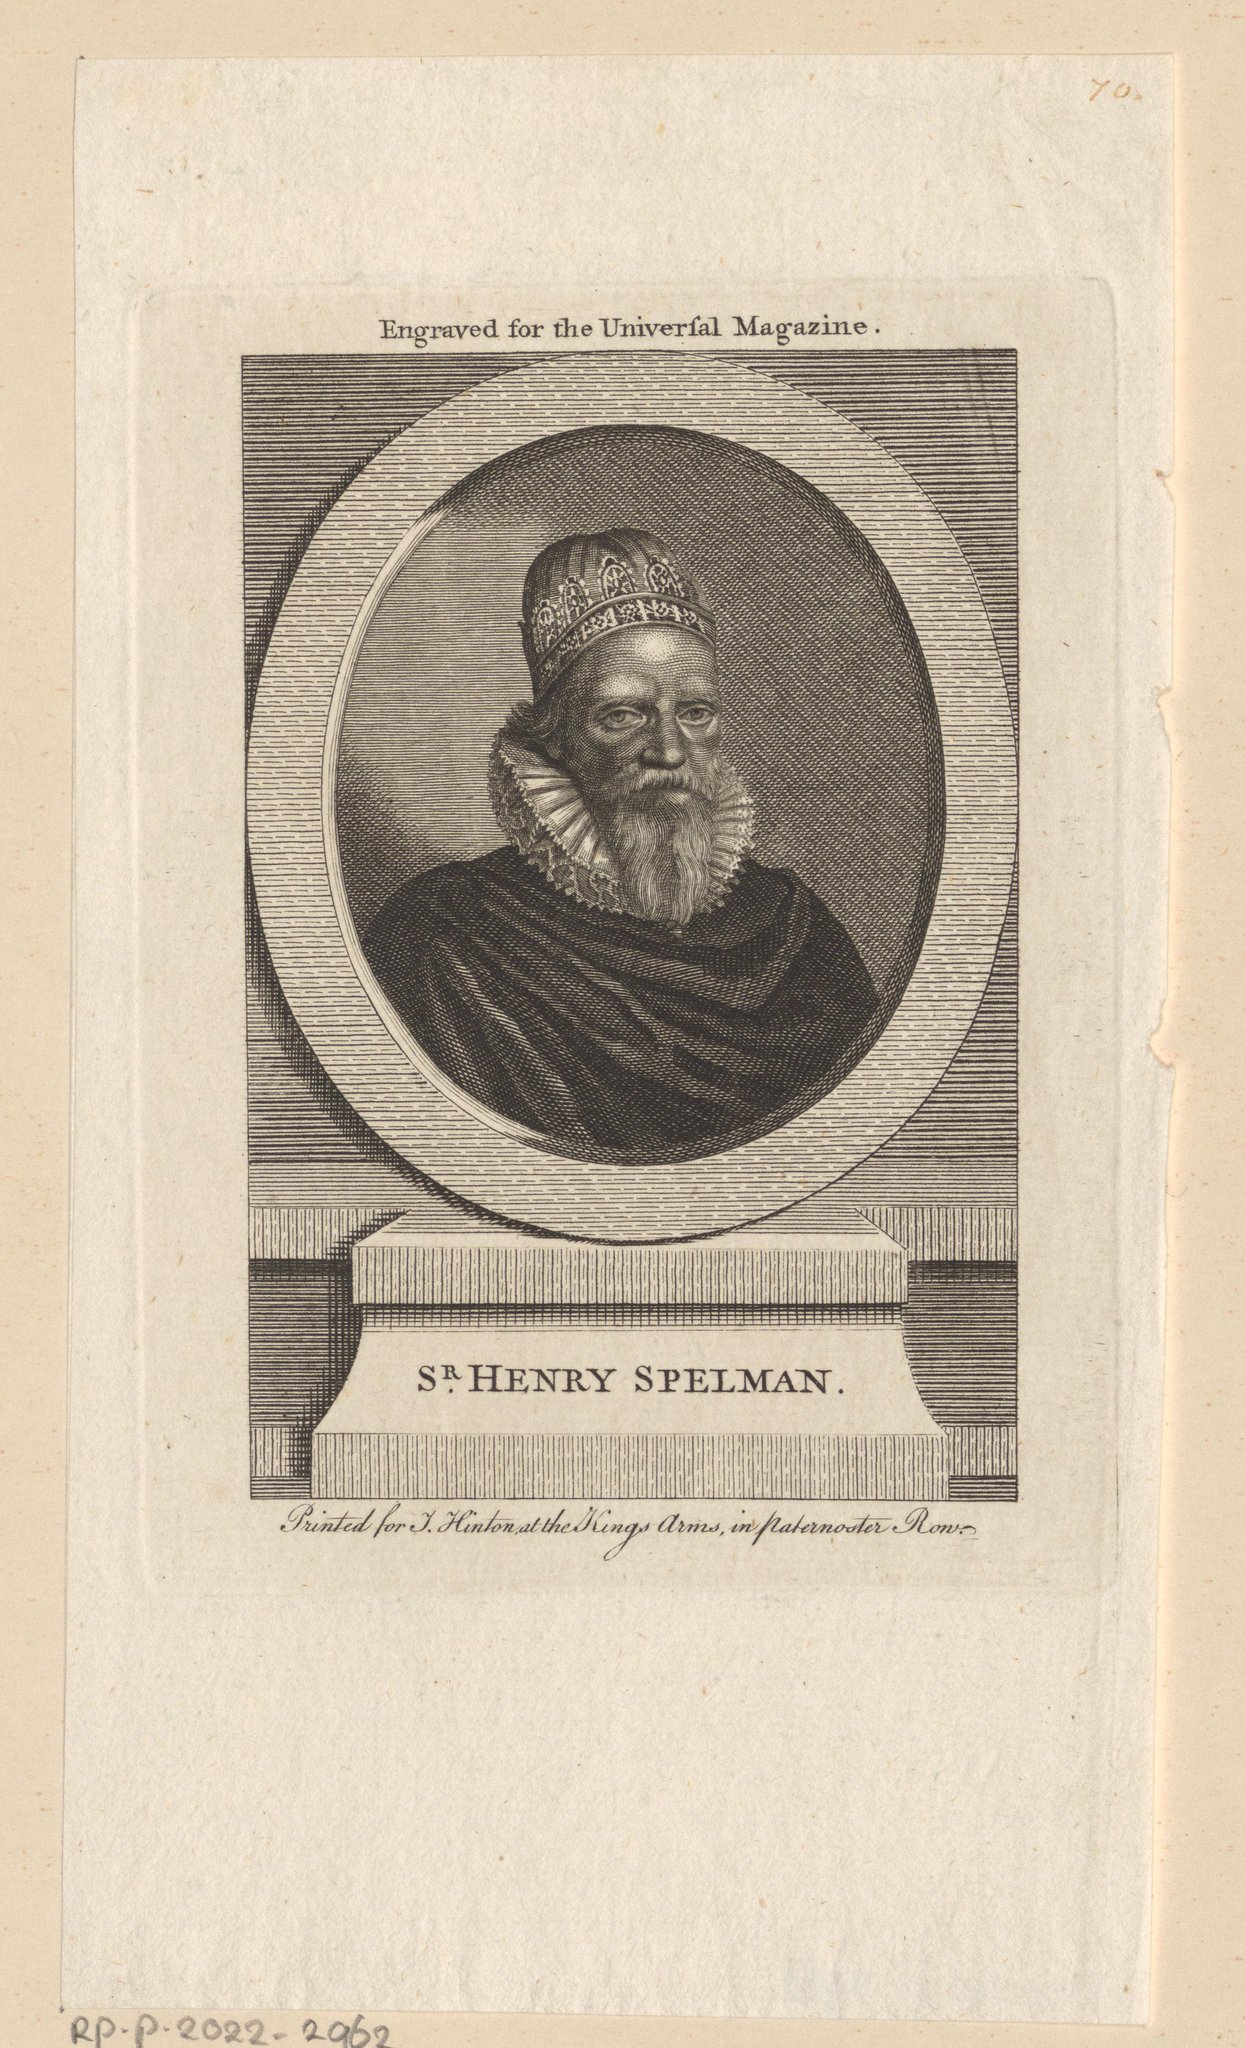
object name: print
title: Portret van Henry Spelman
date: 1747-1781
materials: paper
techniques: engraving, etching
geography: london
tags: antique dealer, historical persons, politician, e.g. party leader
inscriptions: number: ‘70.’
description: Prent uit een deel van The Universal Magazine of Knowledge and Pleasure, [1747-1814].